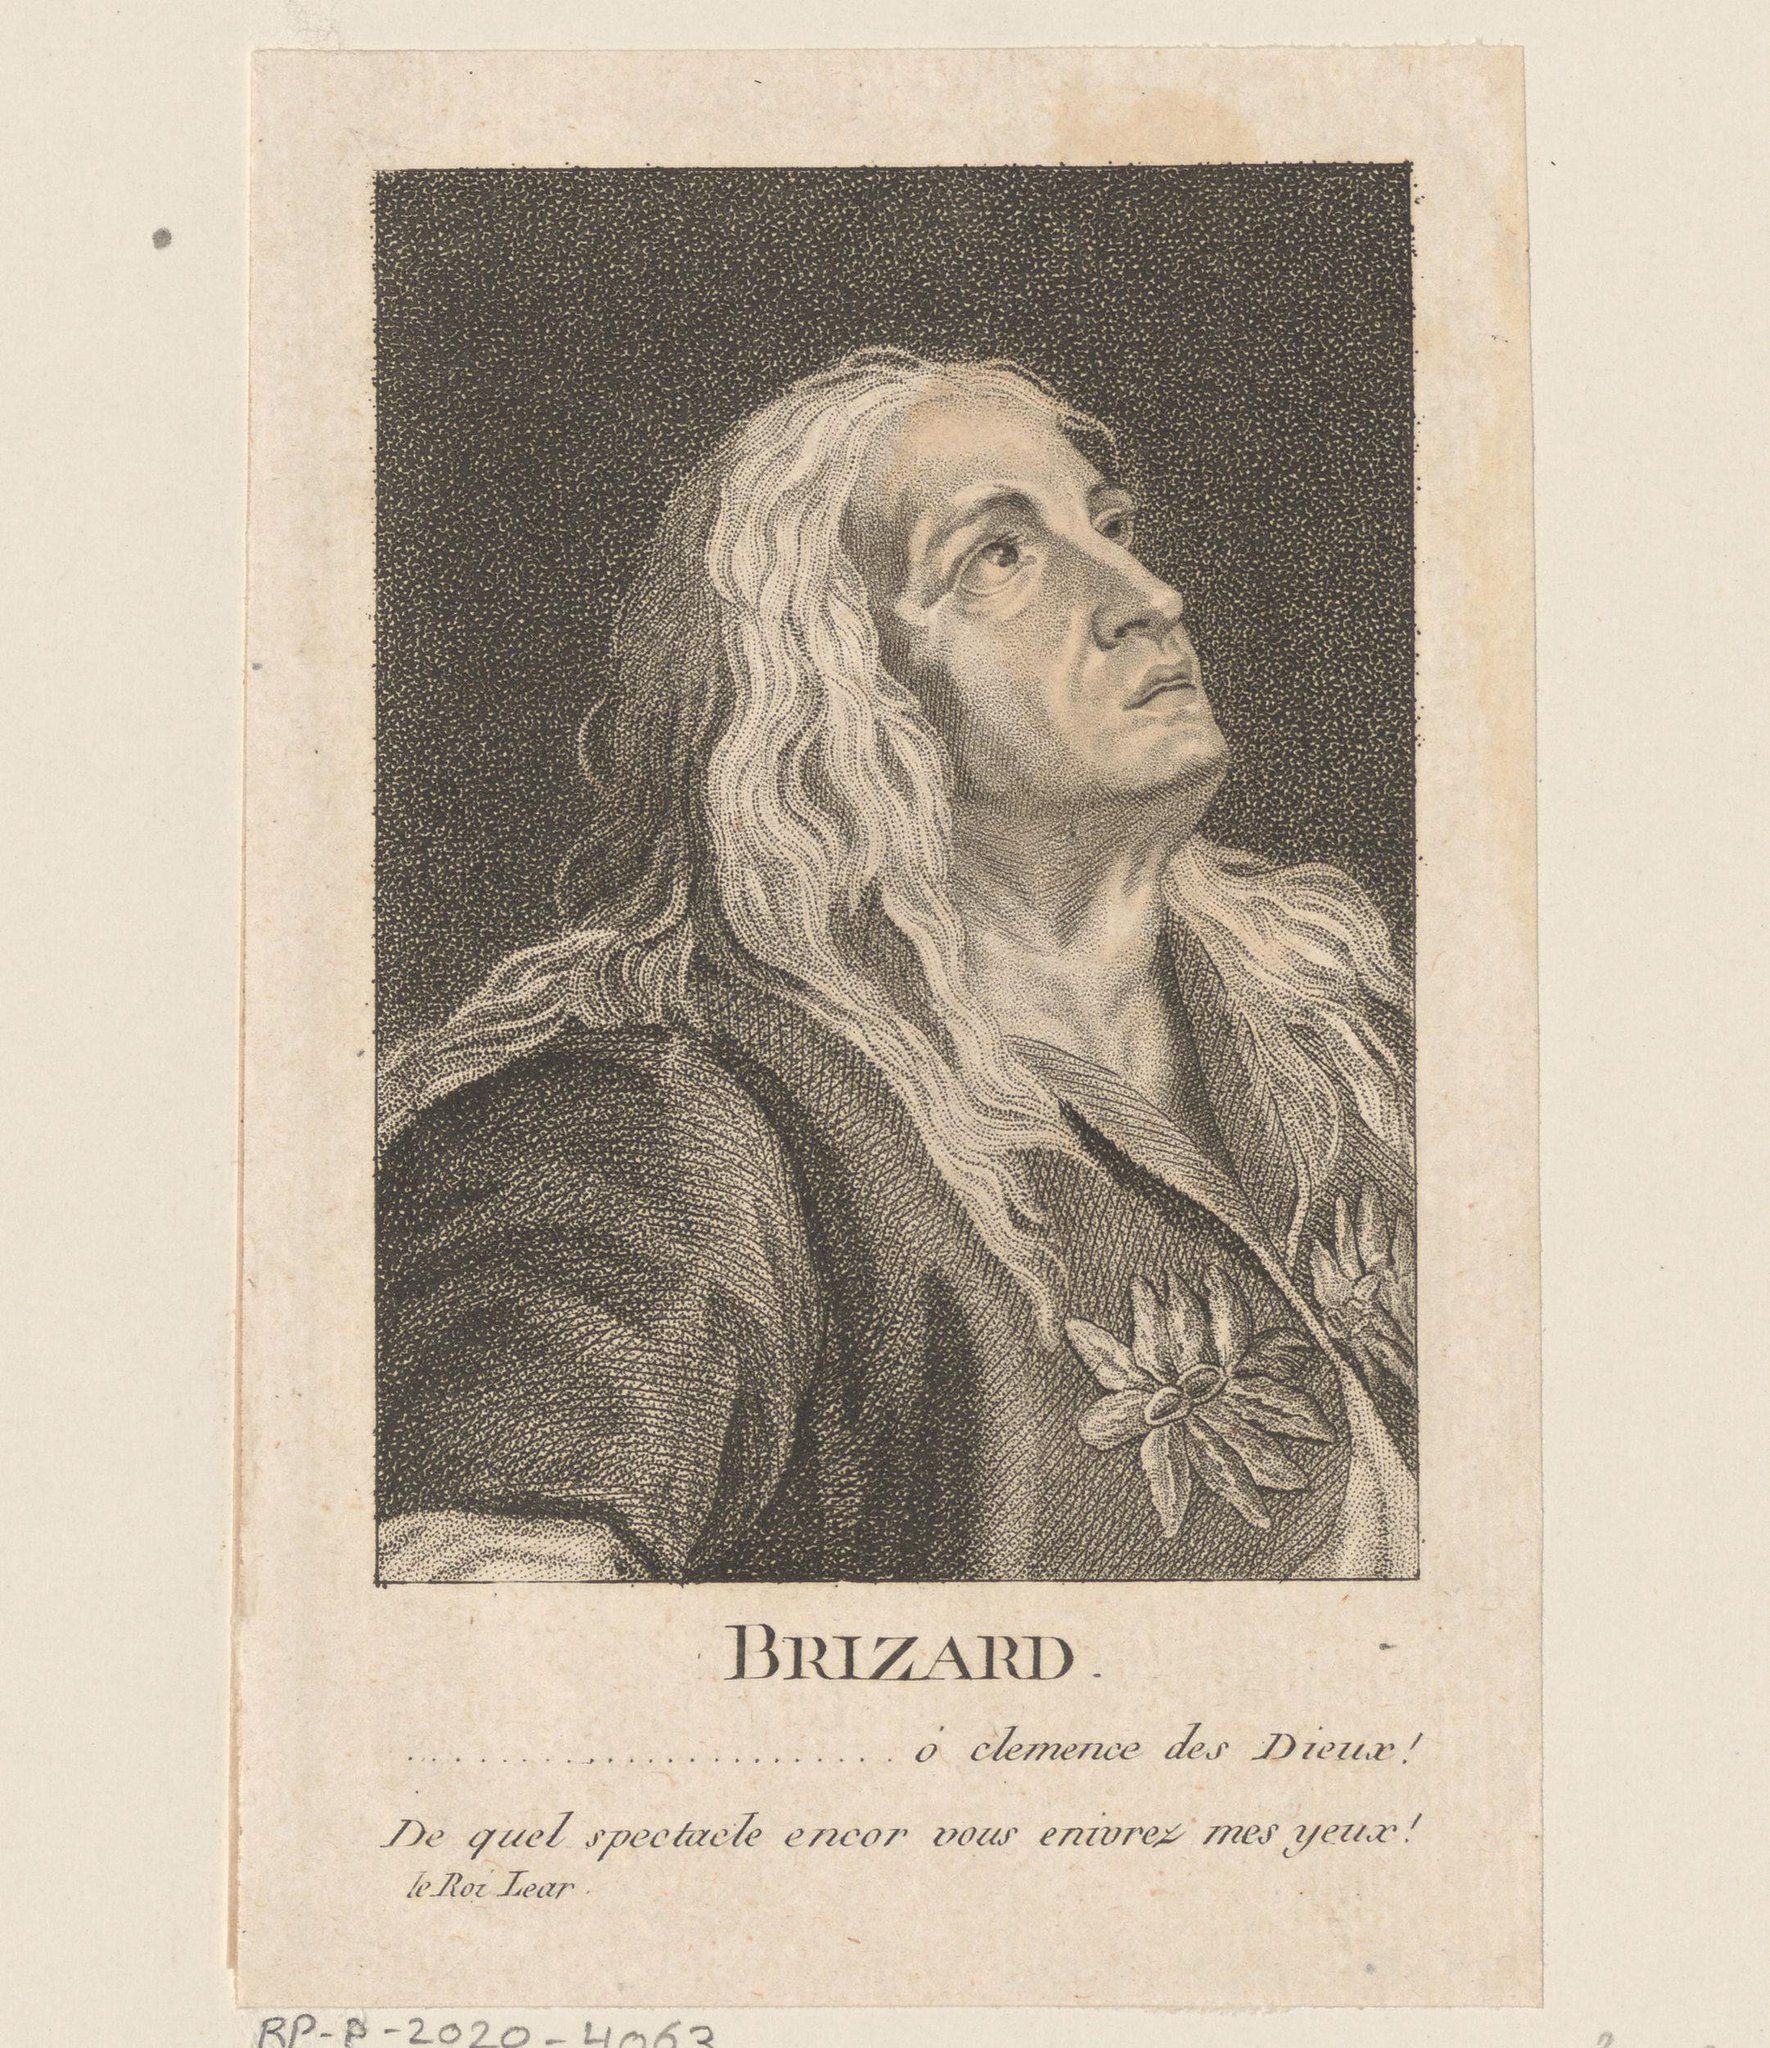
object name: print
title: Portret van Jean-Baptiste Brizard in de rol van koning Lear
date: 1775-1799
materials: paper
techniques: engraving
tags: historical persons, portrait of actor, actress, king lear